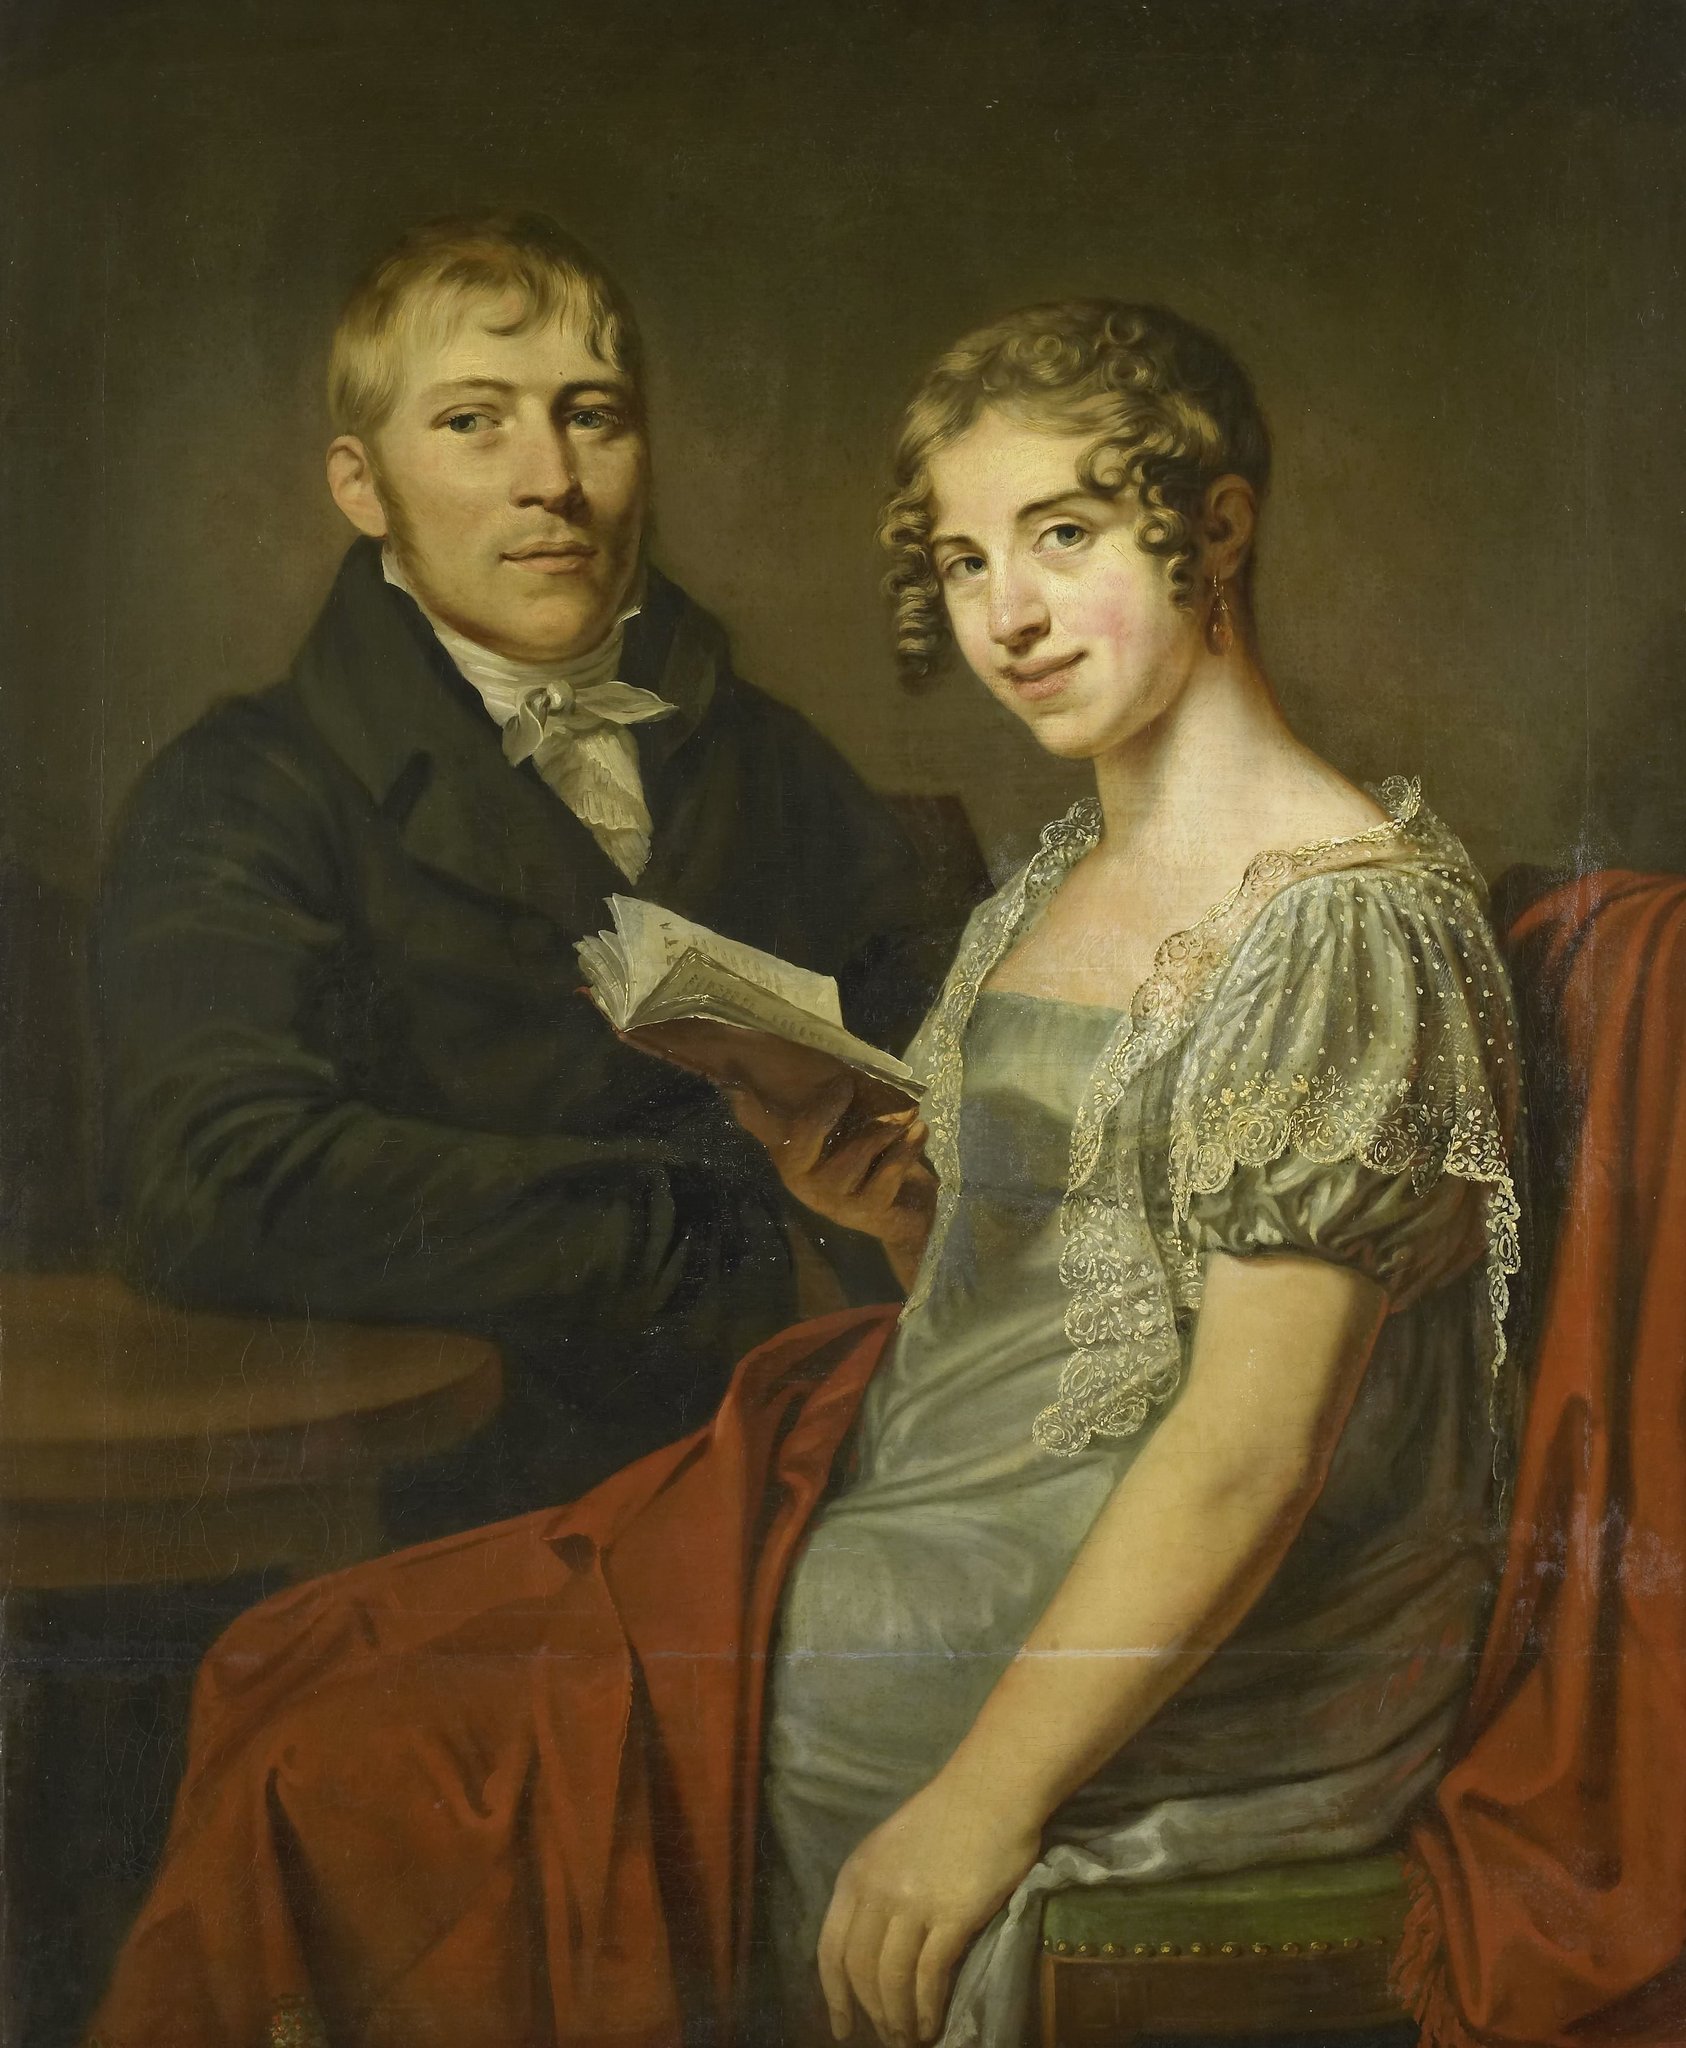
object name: painting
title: Hendrik Arend van den Brink (1783-1852) and his Wife Lucretia Johanna van de Poll (1790-1850)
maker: louis moritz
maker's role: draughtsman, painter, print maker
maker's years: 1773-1850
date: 1805-1830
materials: canvas, oil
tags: historical persons - bb - woman, historical persons, marriage, married couple, 'matrimonium'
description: Portret van Hendrik Arend van den Brink met zijn vrouw Lucretia Johanna van de Poll, beiden zittend aan een tafel. De man leunt met zijn rechterarm op de tafel, de vrouw heeft een boek in de rechterhand.